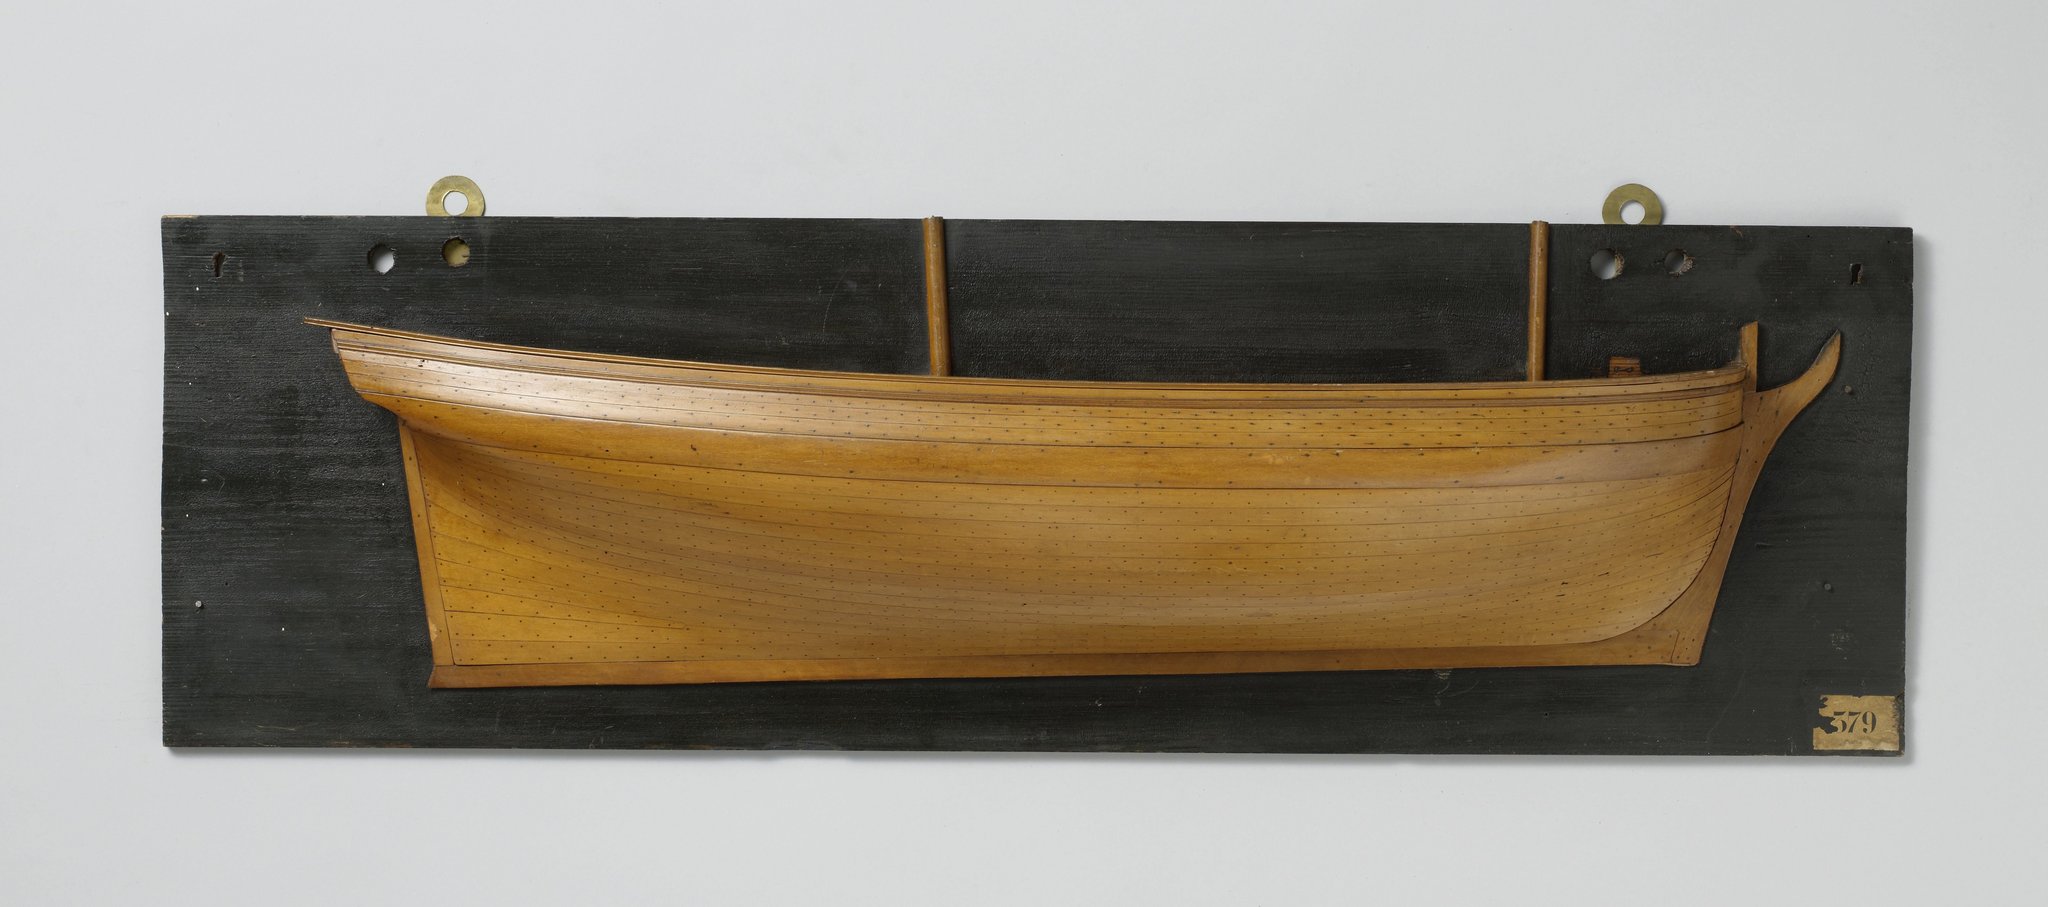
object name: builder's model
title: Half Model of a 14-Gun Brig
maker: Anonymous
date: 1783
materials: wood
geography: netherlands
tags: pijl (schip)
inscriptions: label, bottom right: ‘379’ former inventory label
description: Beplankt mallenmodel (stuurboord) van een tweemaster. Het dek is gesloten en de plaats van de luiken is aangegeven. Rond voorschip met bijna verticale voorsteven. Gewrongen spiegel, hol wulf, het hek ontbreekt, geen zijgalerij, geen roer. Zeeg naar achteren oplopend, één barkhout en twee reehouten. Gepiekt rondspant.